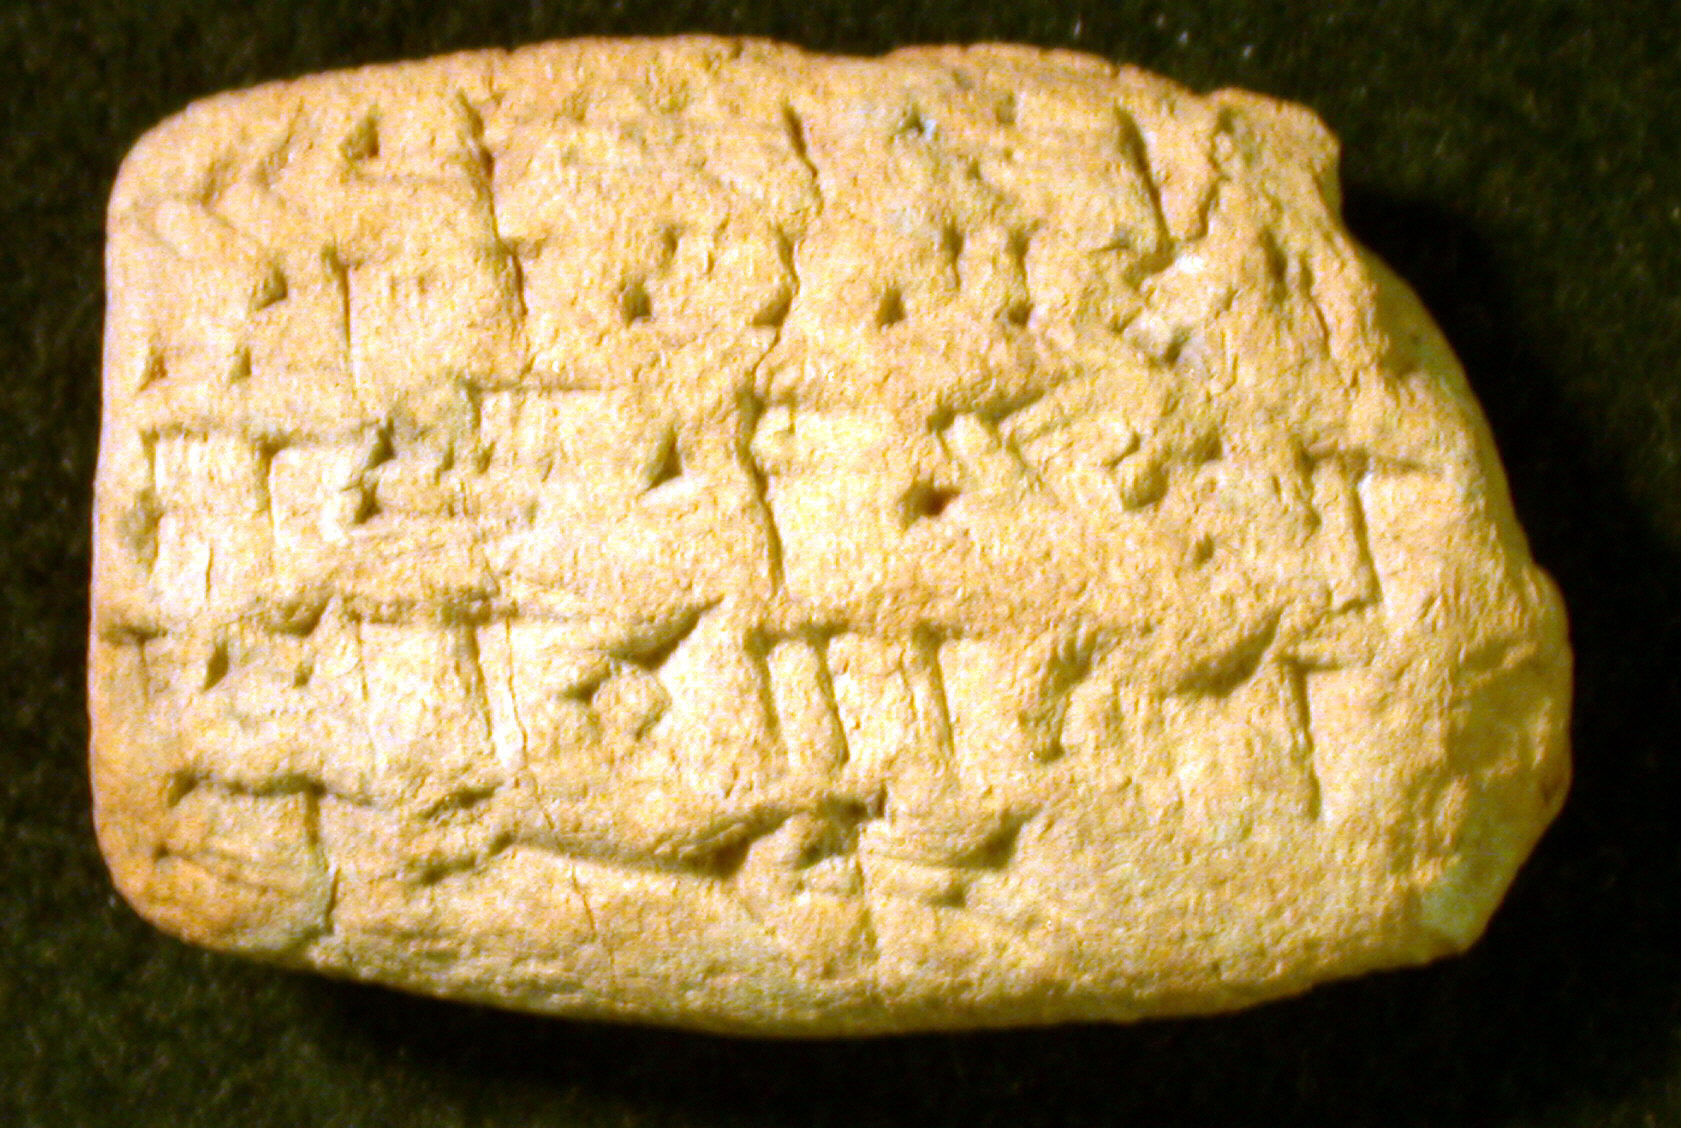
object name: cuneiform tablet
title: Cuneiform tablet: account regarding baskets, Ebabbar archive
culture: babylonian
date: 574 BCE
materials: clay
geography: mesopotamia